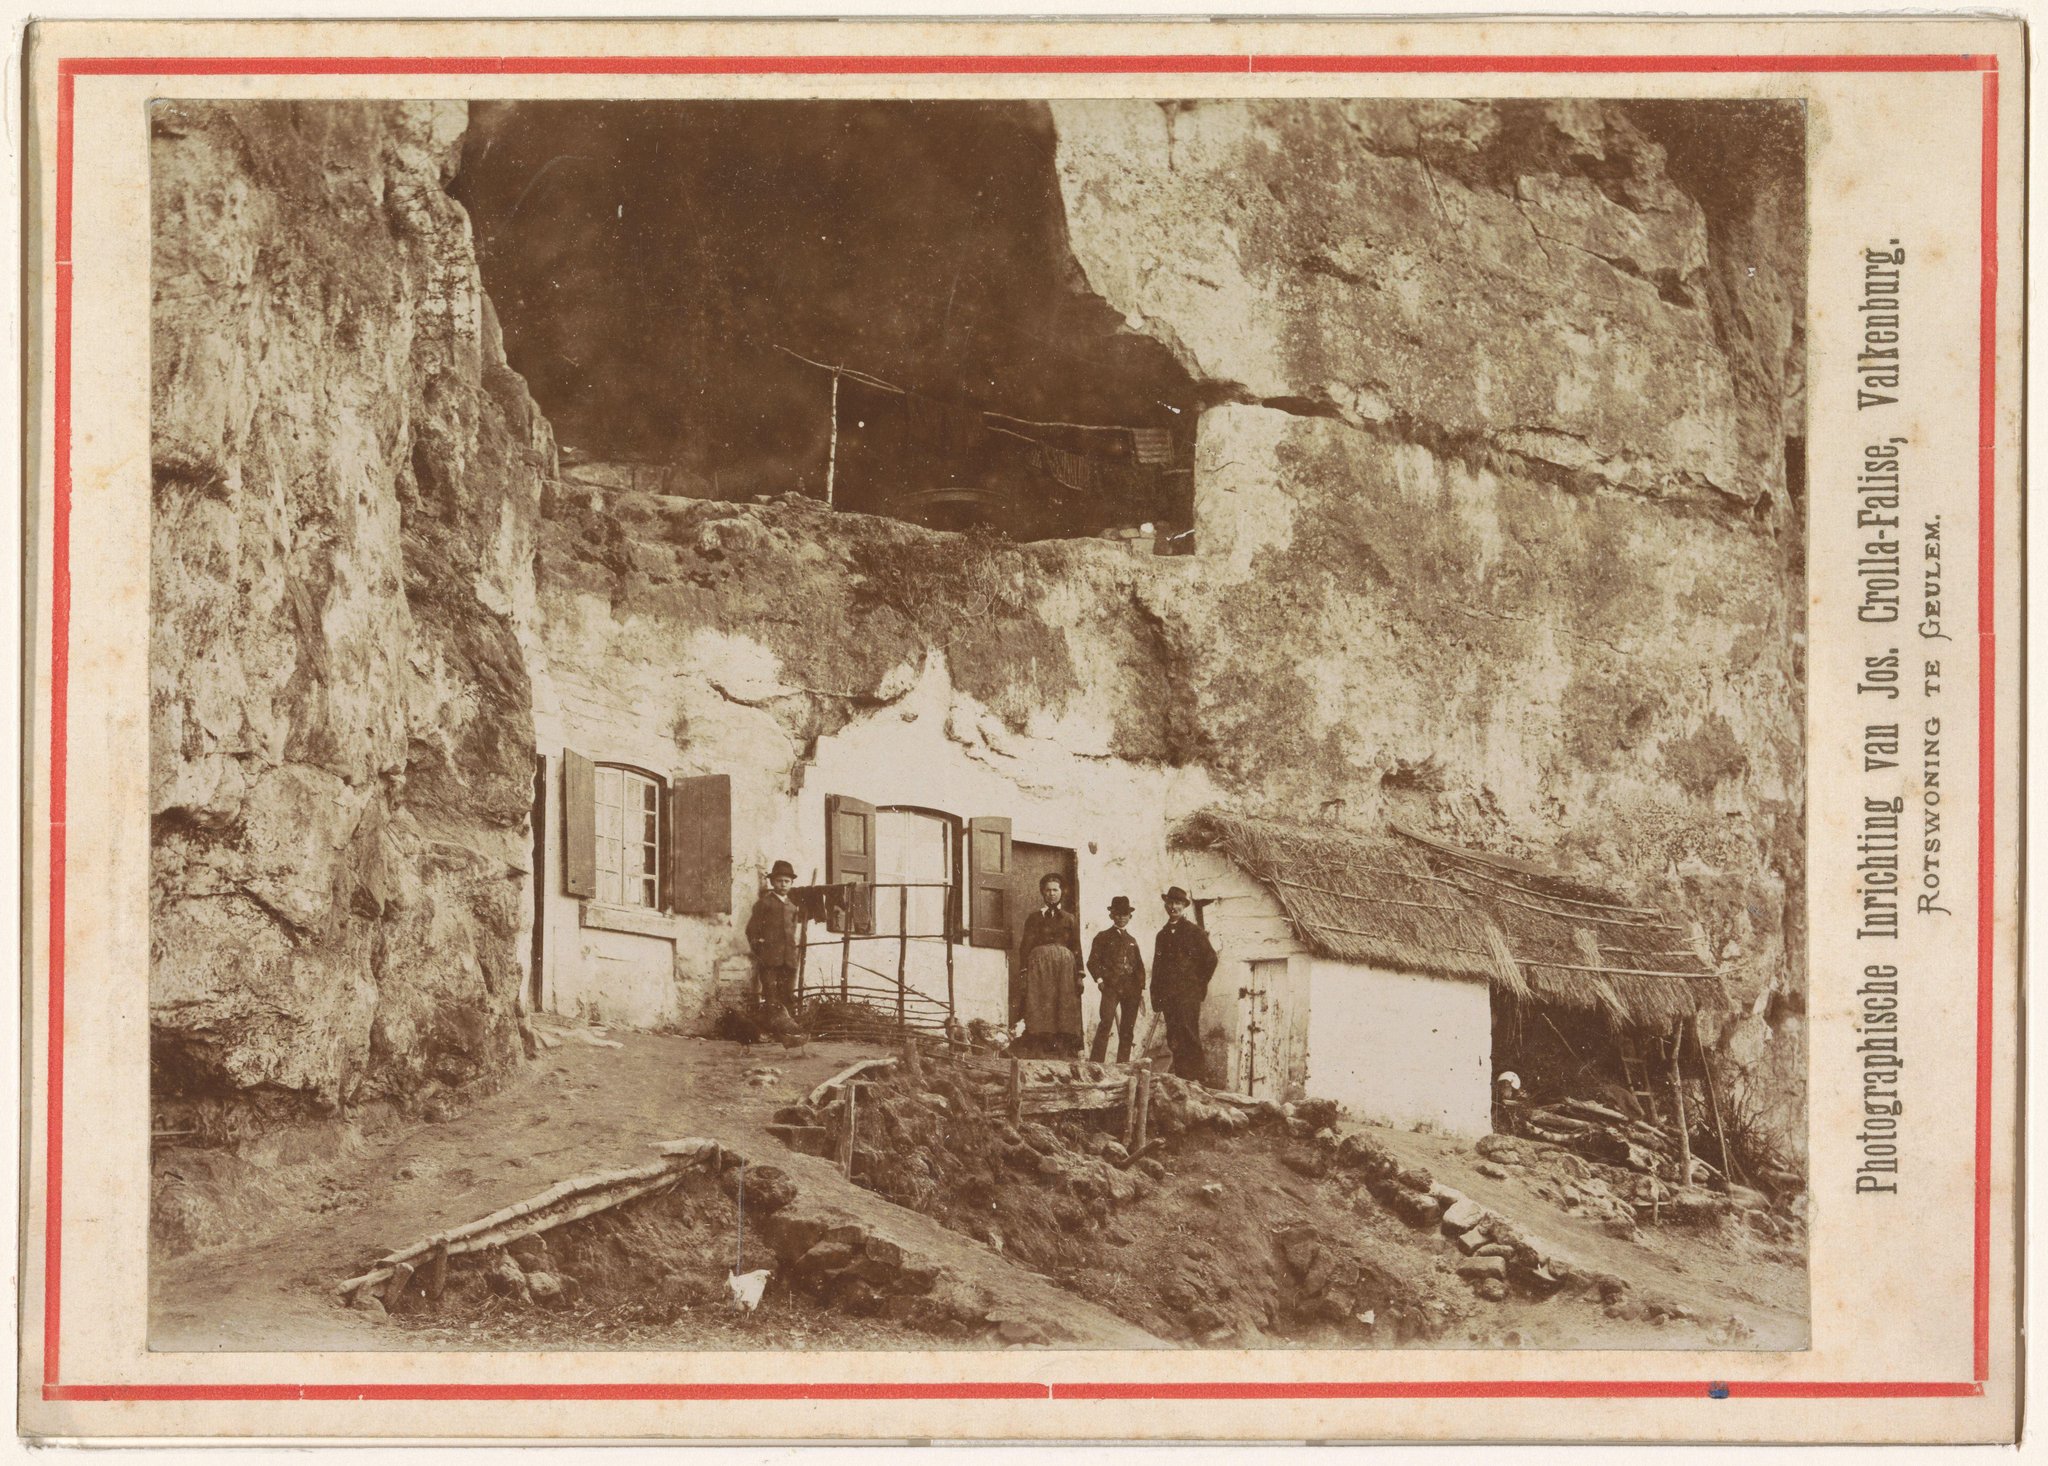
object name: photograph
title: Rotswoning te Geulhem, Limburg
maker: jos. crolla-falise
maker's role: printer, publisher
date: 1880-1920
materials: cardboard, paper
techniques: albumen print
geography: valkenburg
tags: rock-formations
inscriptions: company name: ‘Stoomdrukkerij boekhandel boekbinderij Jos. Crolla-Falise, Valkenburg. Alle mogelijke photographien van Valkenburg en omstreken, Steeds te ontbieden voor het opnemen van groepen, enz.’, signature: ‘Photographische inrichting van Jos. Crolla-Falise, Valkenburg’, title: ‘Rotswoning te Geulem’